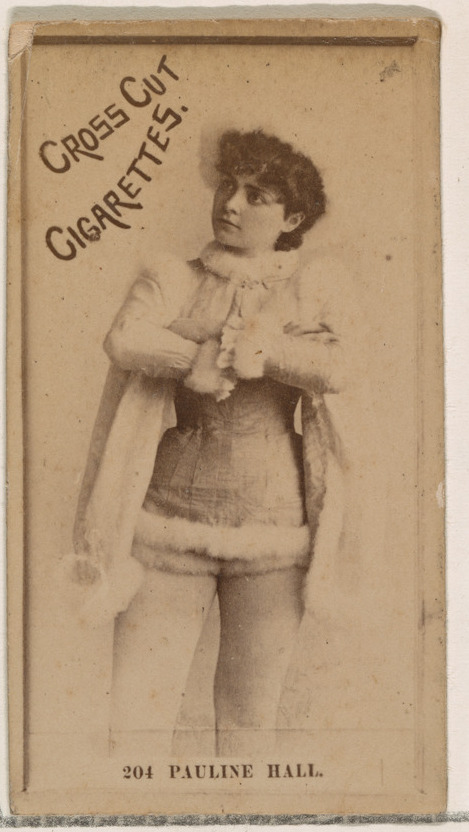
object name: print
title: Card Number 204, Pauline Hall, from the Actors and Actresses series (N145-2) issued by Duke Sons & Co. to promote Cross Cut Cigarettes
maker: w. duke, sons & co.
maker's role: publisher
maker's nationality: american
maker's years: 1870-1920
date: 1880-1889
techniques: albumen silver print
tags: portraits,women,actresses